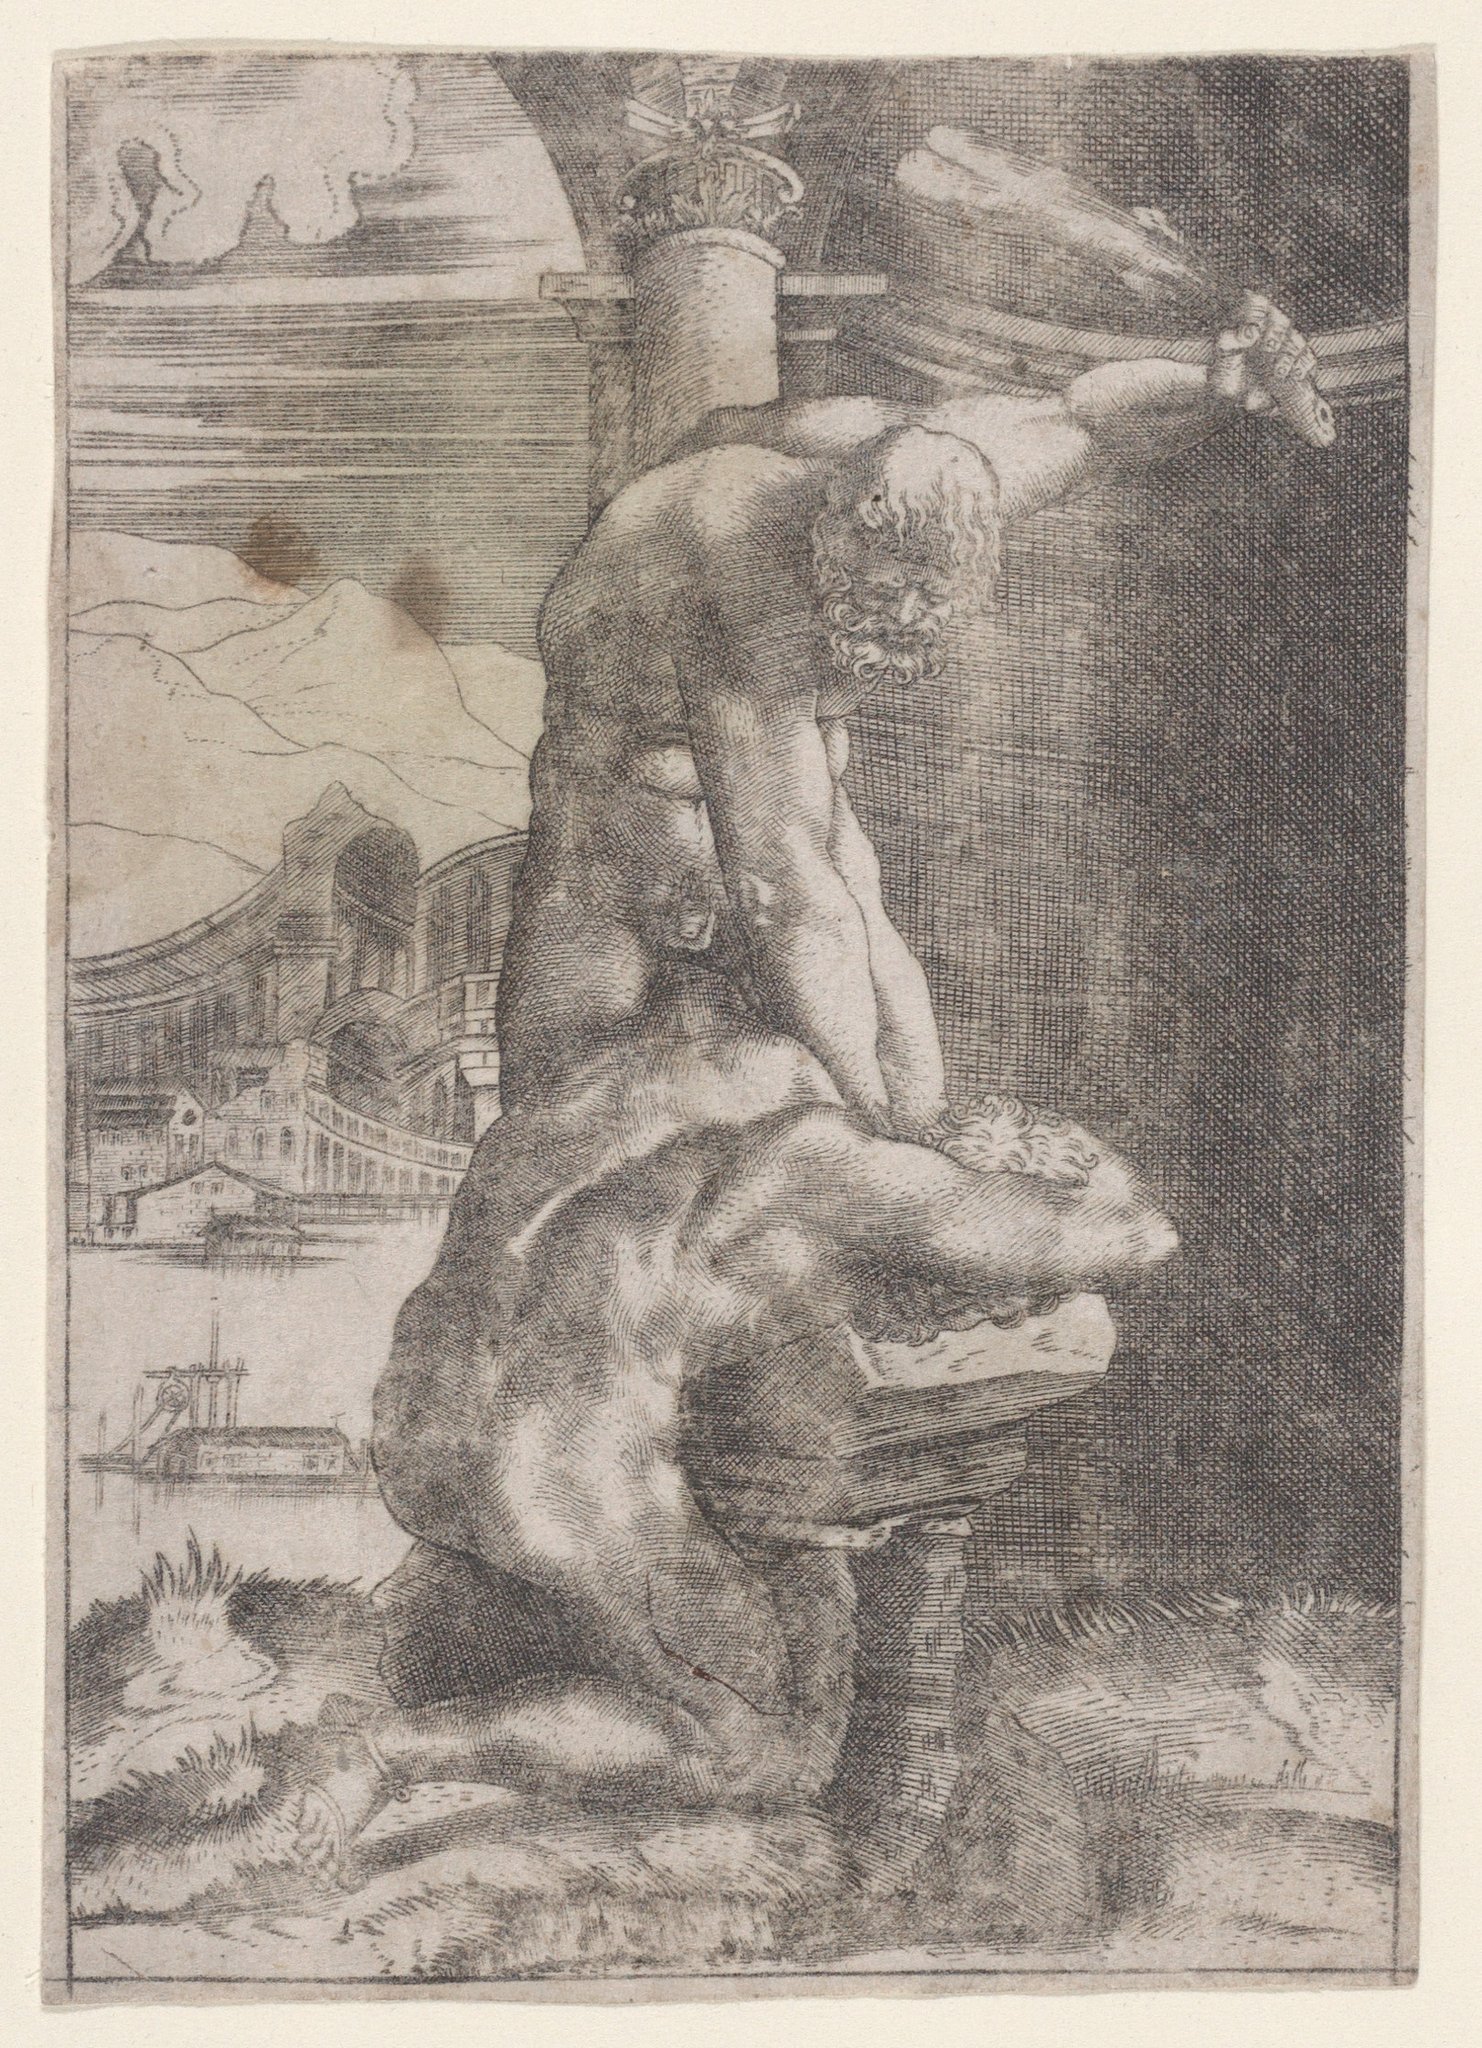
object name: print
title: One Man Striking Another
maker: agostino veneziano (agostino dei musi)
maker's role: artist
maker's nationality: italian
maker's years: 1490-1536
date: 1514-1536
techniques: engraving